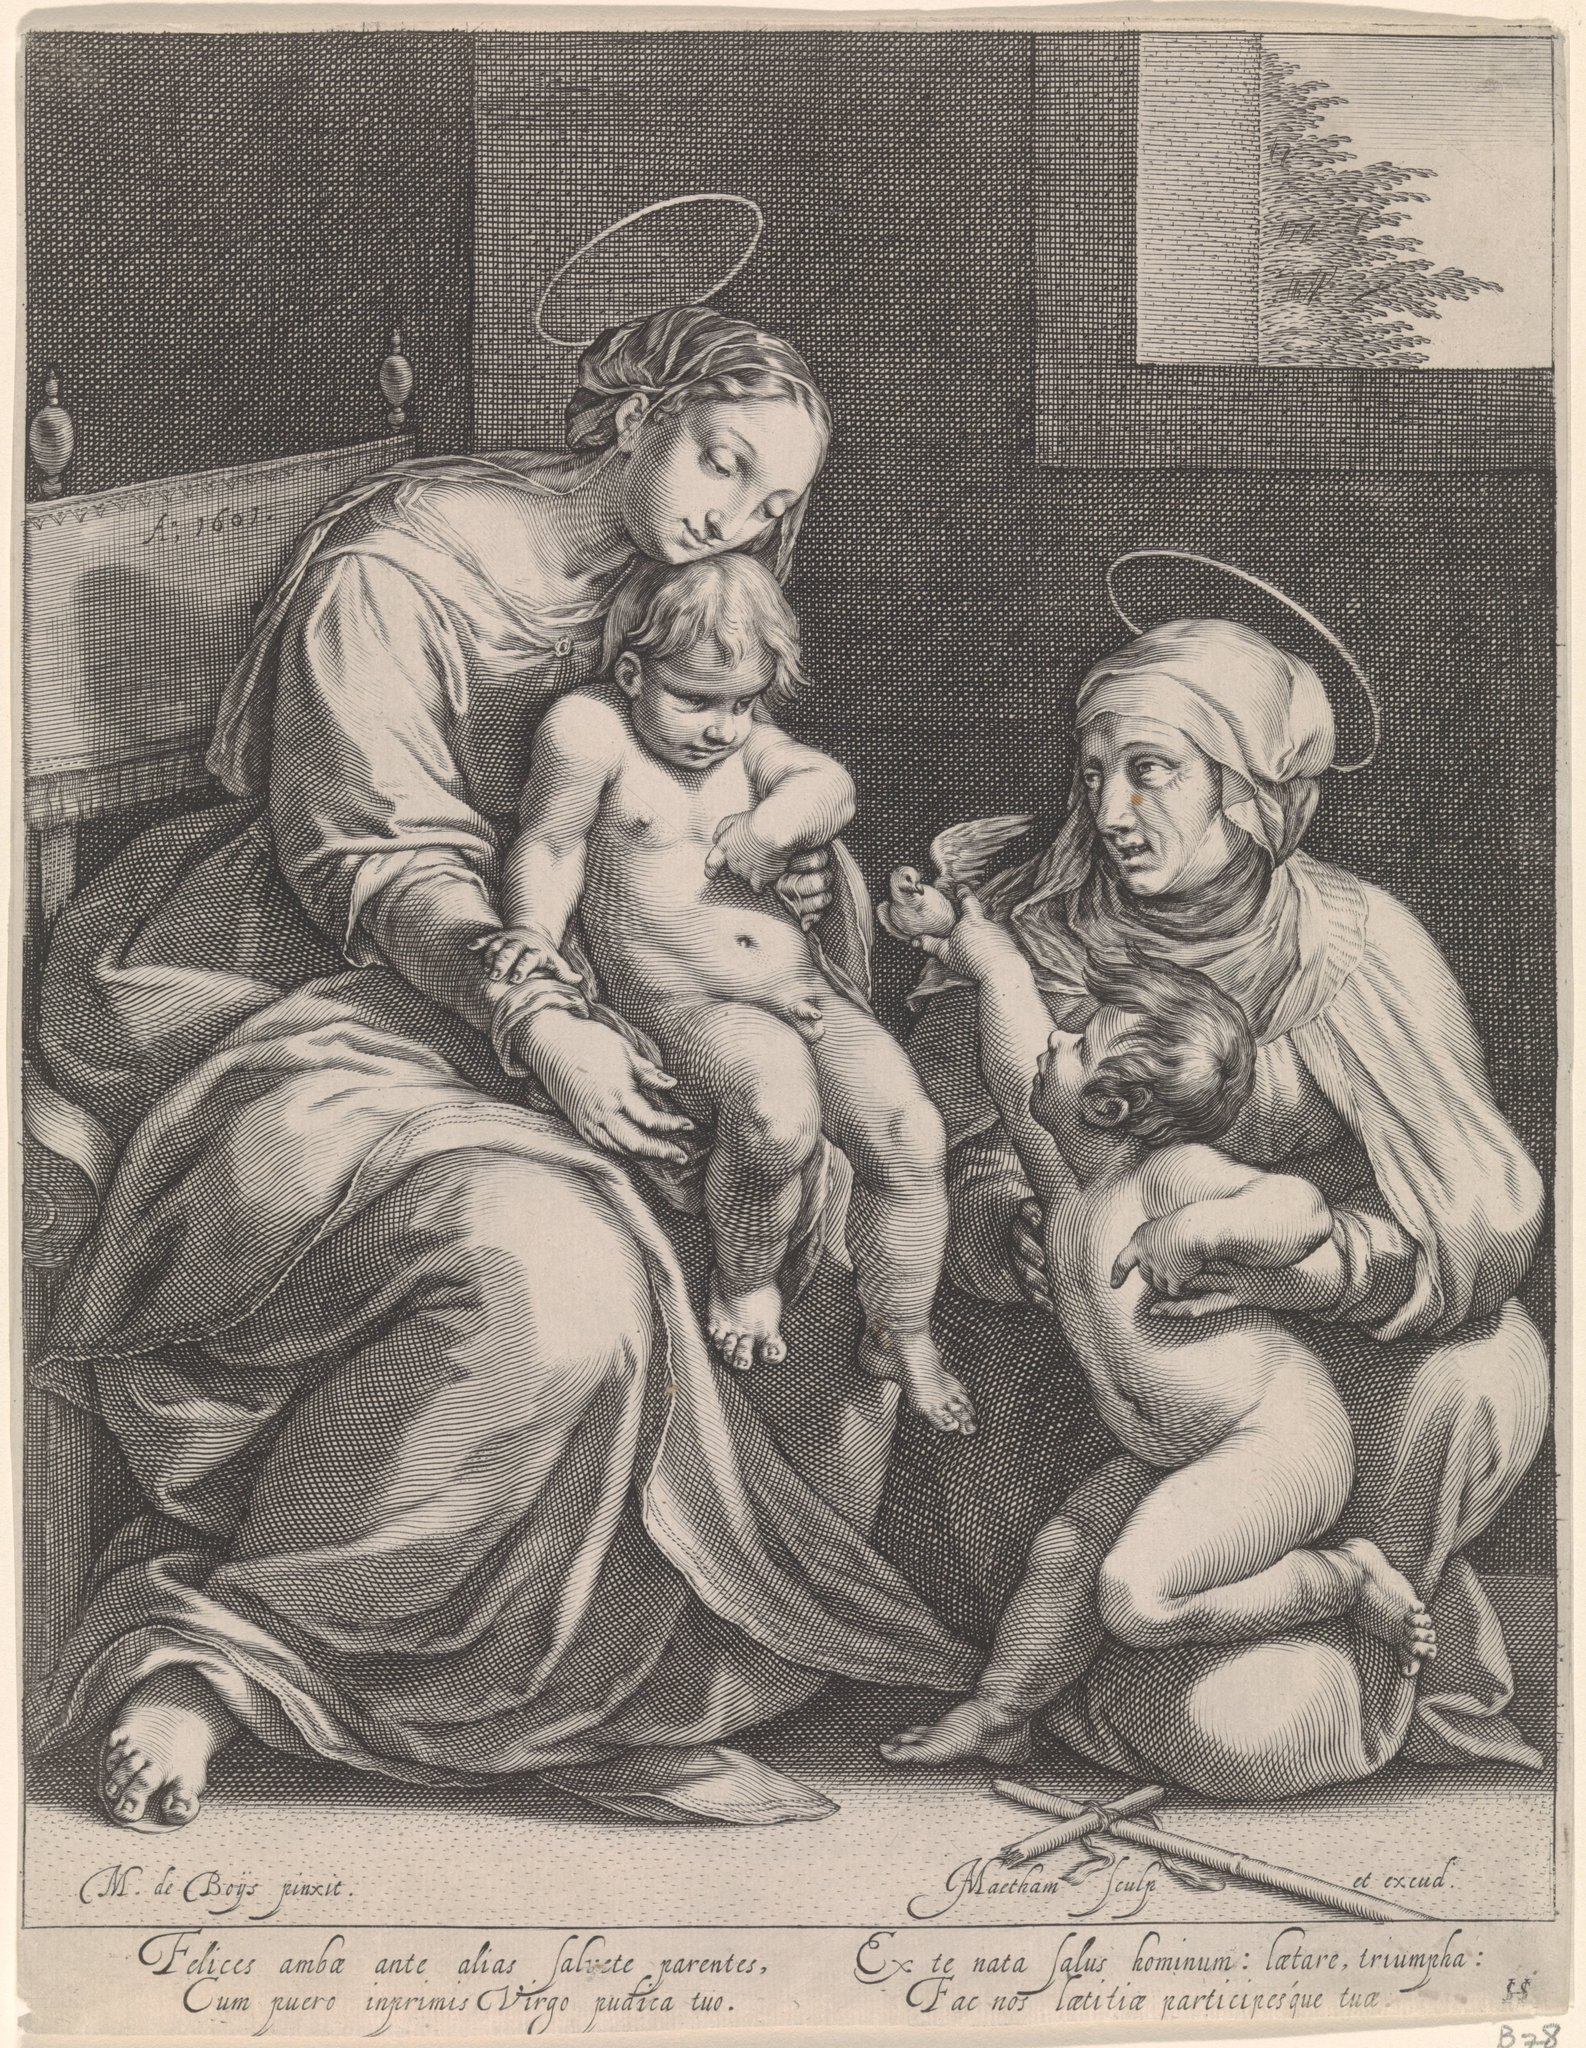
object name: print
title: Maria met Christuskind en Elisabet met de kleine Johannes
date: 1607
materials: paper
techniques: engraving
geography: haarlem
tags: mary, the christ-child and john the baptist, elisabeth present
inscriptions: collector's mark: Lugt 240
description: Maria met Christuskind zittend op een stoel, met voor haar Elisabet met het kind Johannes dat het Christuskind een vogel aanbiedt.